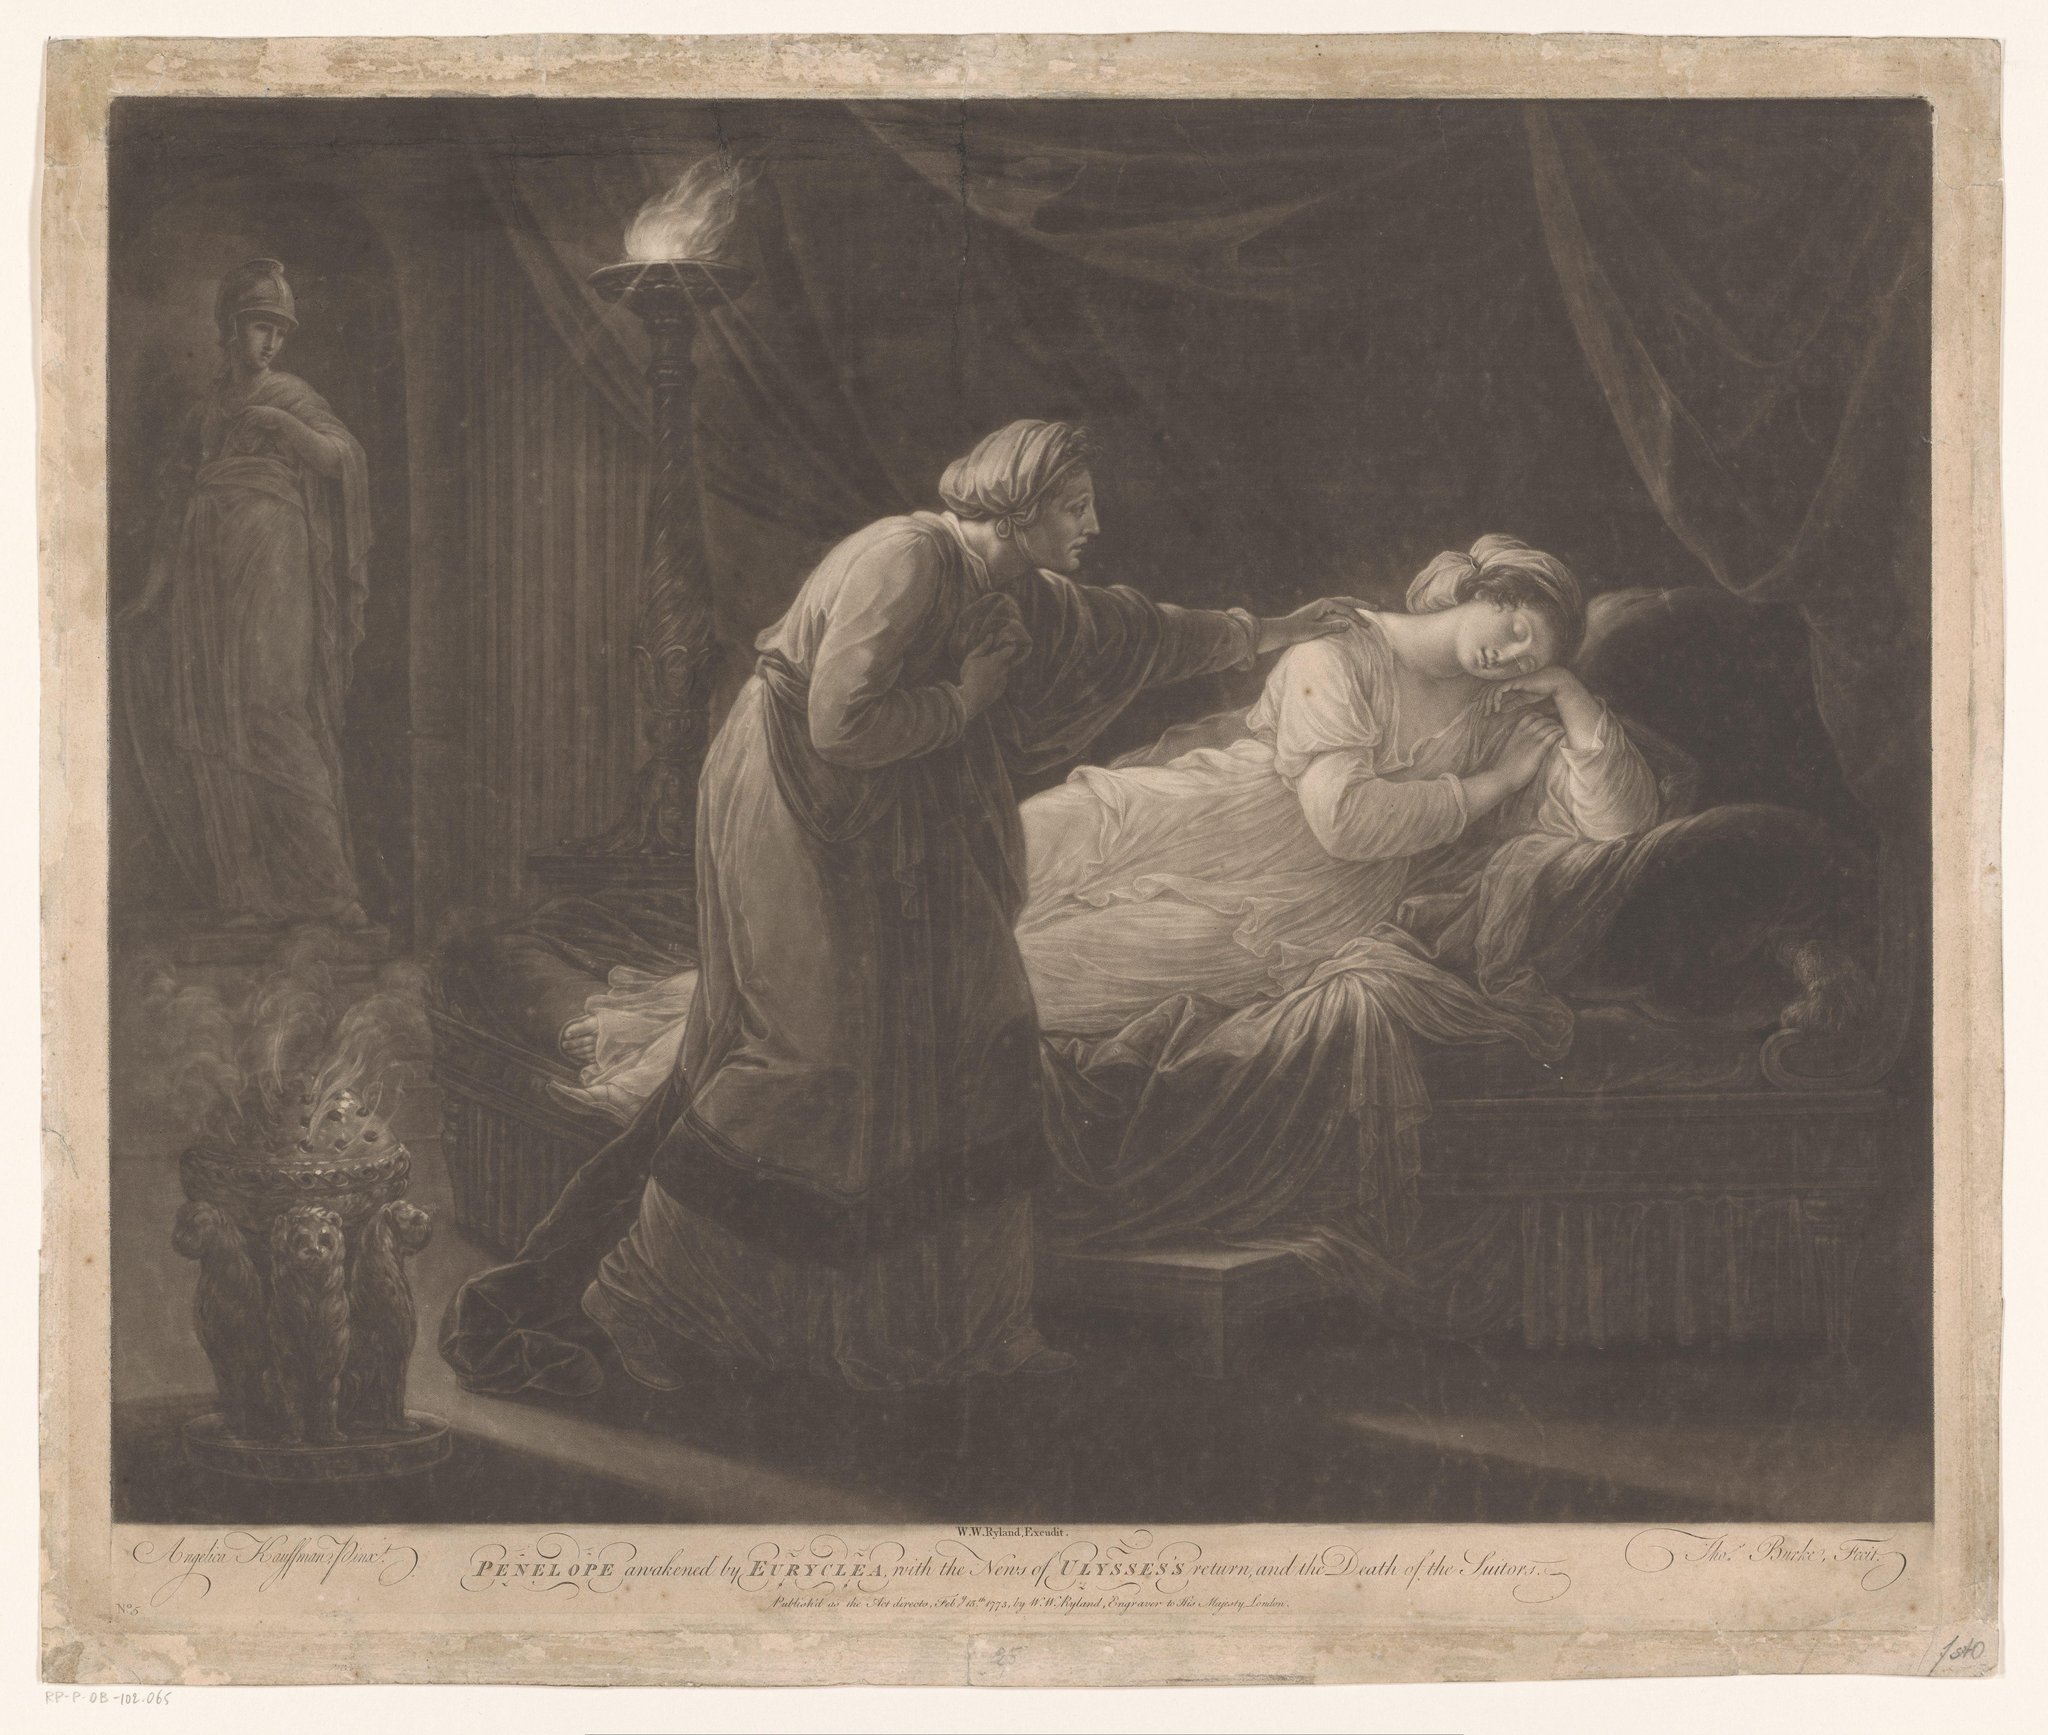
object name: print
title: Penelope wordt gewekt door Euryclea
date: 1702-1773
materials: paper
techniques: etching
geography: london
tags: euryclea fetches penelope, (story of) minerva (pallas, athena), sleeping in bed, incense-burner ~ scents, perfumes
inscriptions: collector's mark: Lugt 2228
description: Penelope ligt te slapen op een bed onder een baldakijn. Euryclea maakt haar wakker met het bericht van de terugkomt van Odysseus. Links een wierookvat en een beeld van Minerva.